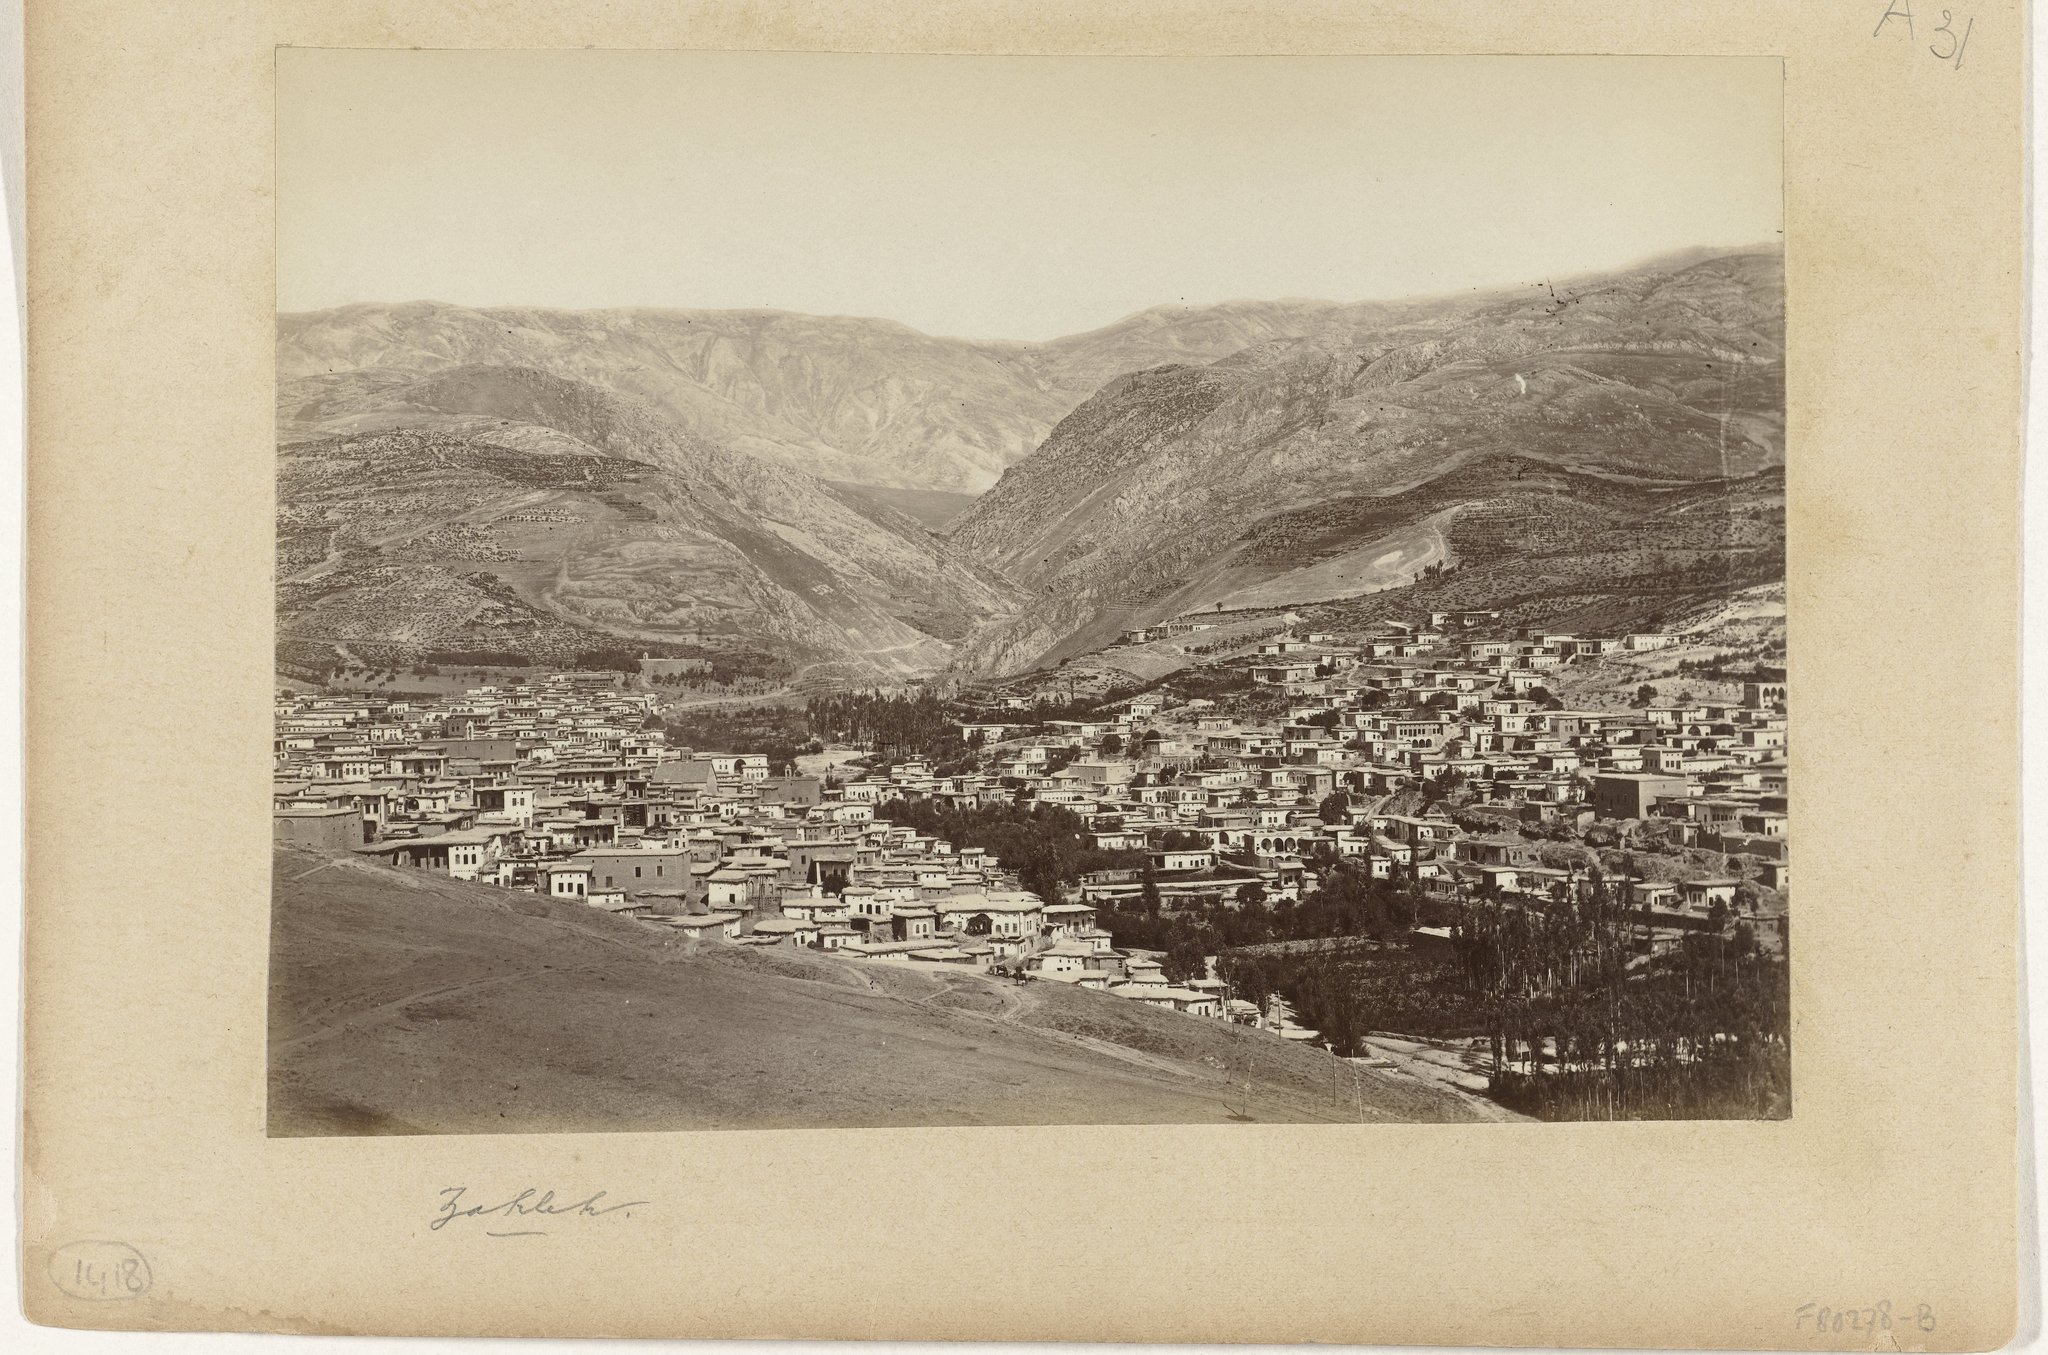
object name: photograph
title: Zahleh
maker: Anonymous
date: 1855-1900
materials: cardboard, paper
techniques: albumen print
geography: lebanon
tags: city-view in general; 'veduta'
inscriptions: number: ‘A31/ 1418’